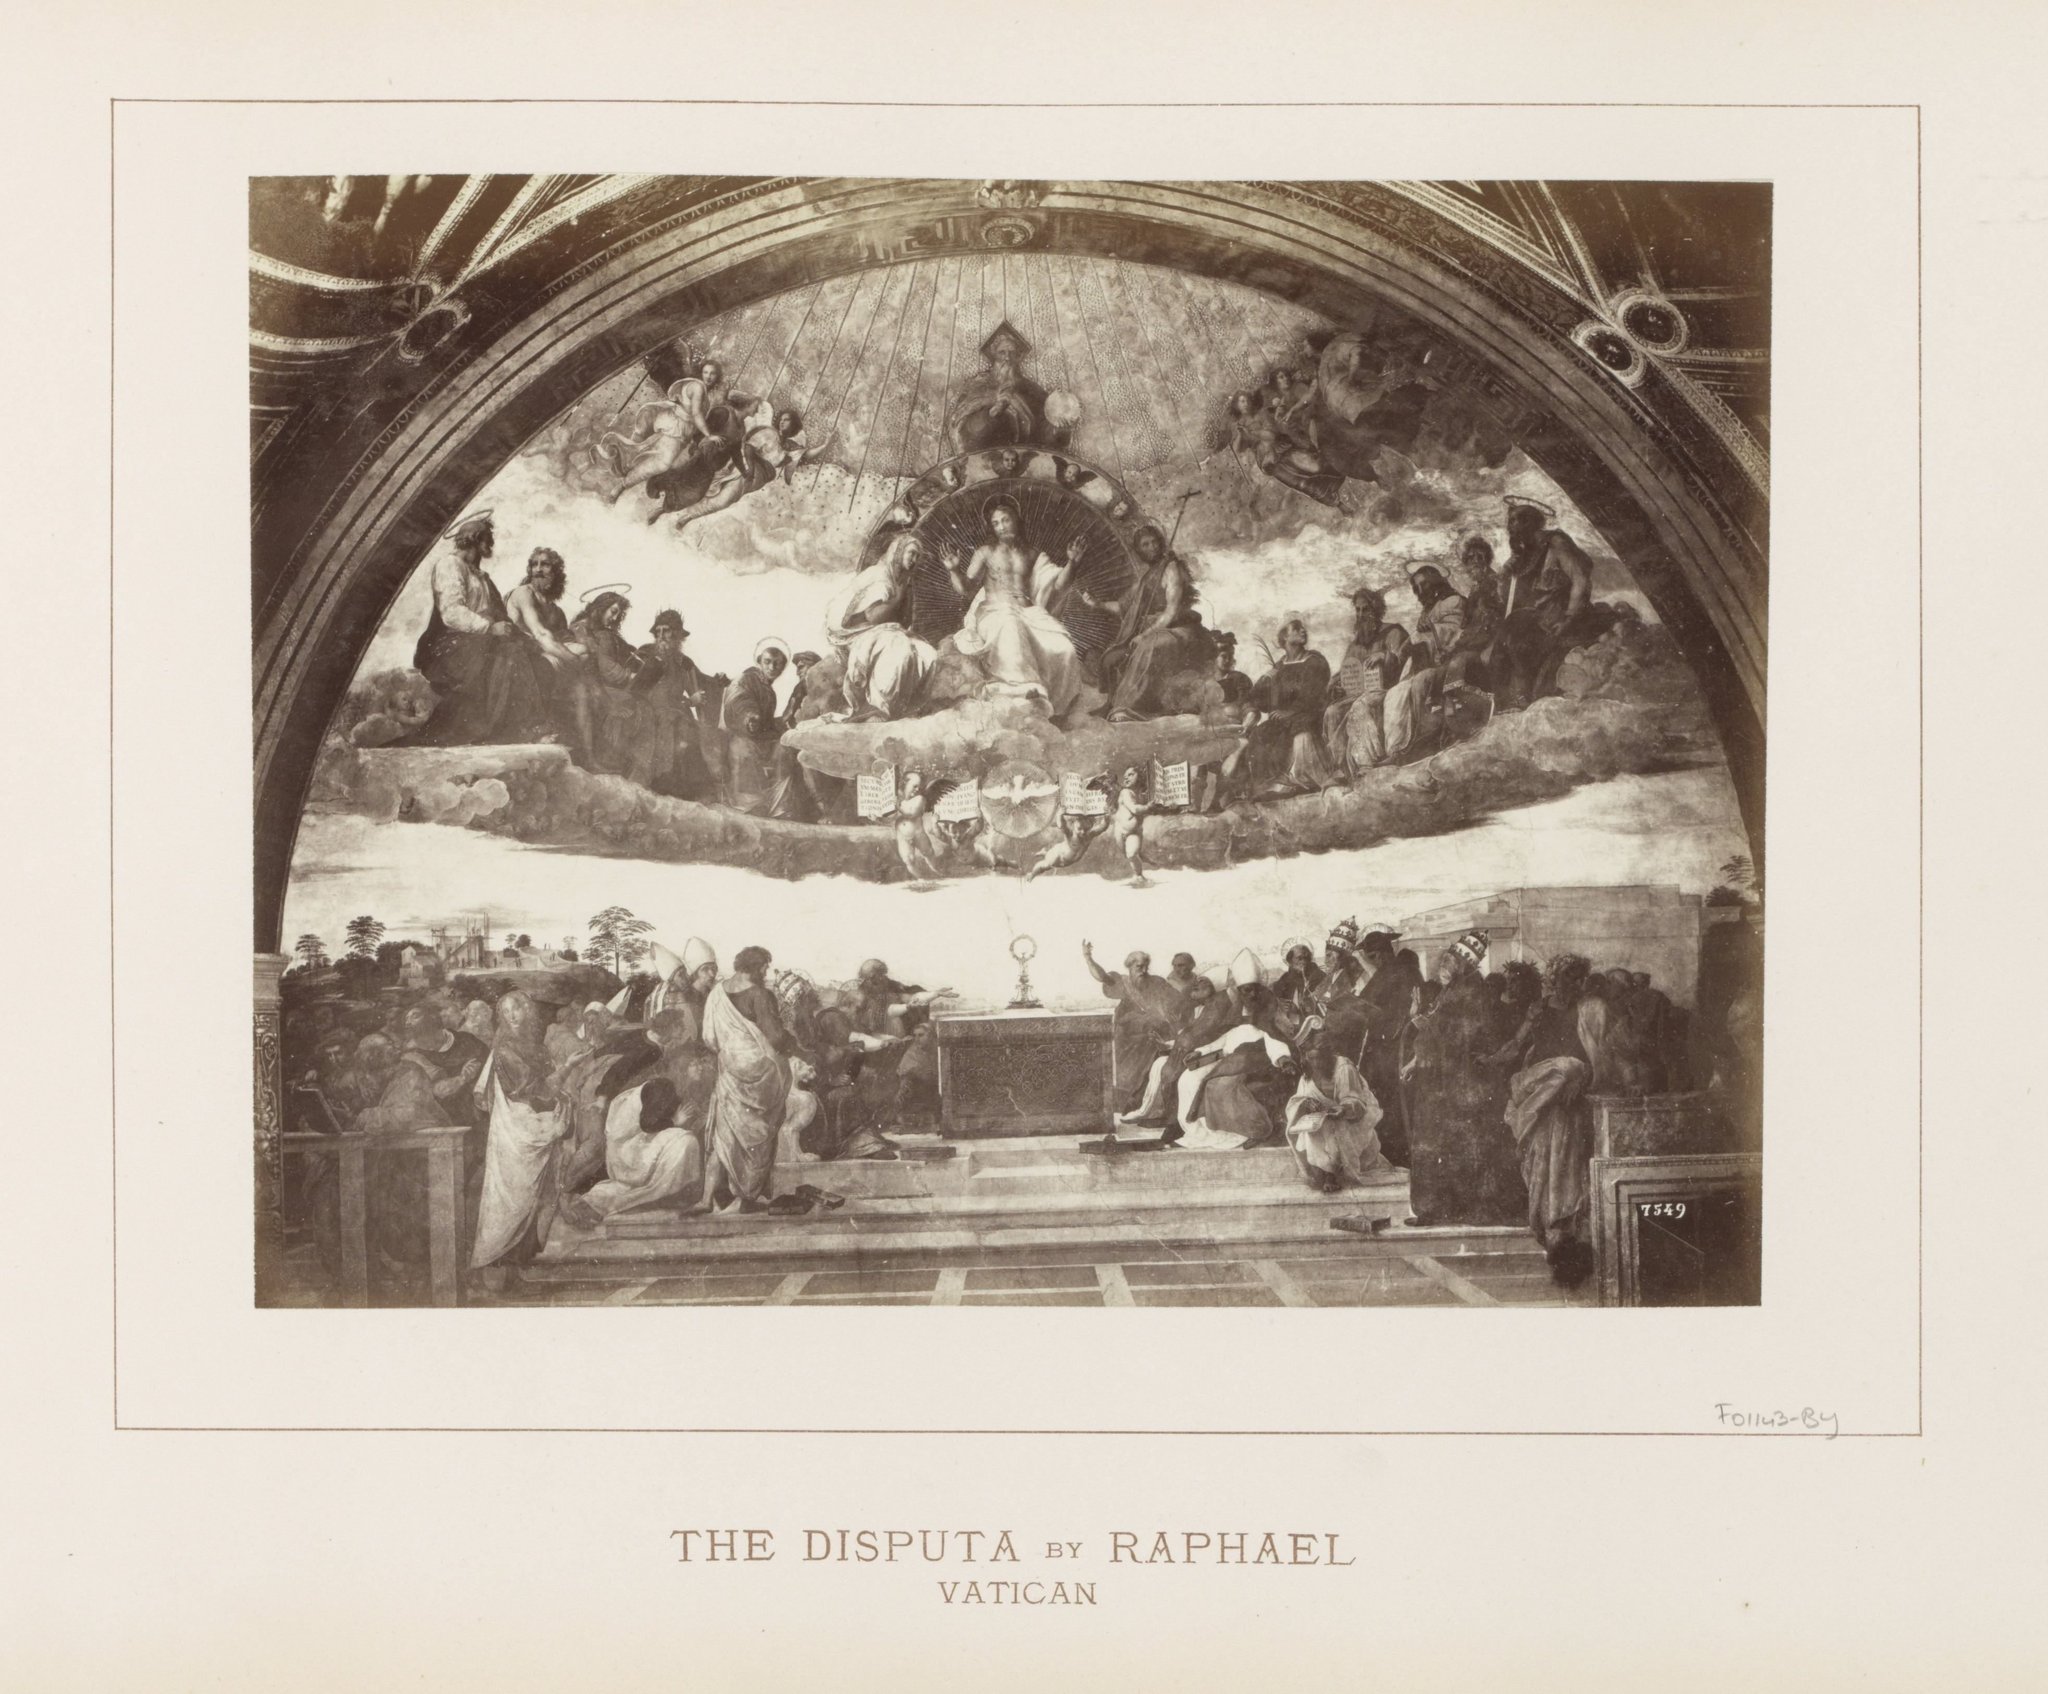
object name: reproduction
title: The Disputa by Raphael, Vatican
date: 1860-1900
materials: photographic support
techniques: albumen print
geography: apostolisch paleis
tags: dante alighieri, rome, priest, politician, representations of the trinity, the holy trinity, 'trinitas coelestis'; father, son and holy ghost ~ christian religion, saints, pope, angels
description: Onderdeel van Fotoalbum met opnames van bezienswaardigheden en kunstwerken in Rome.